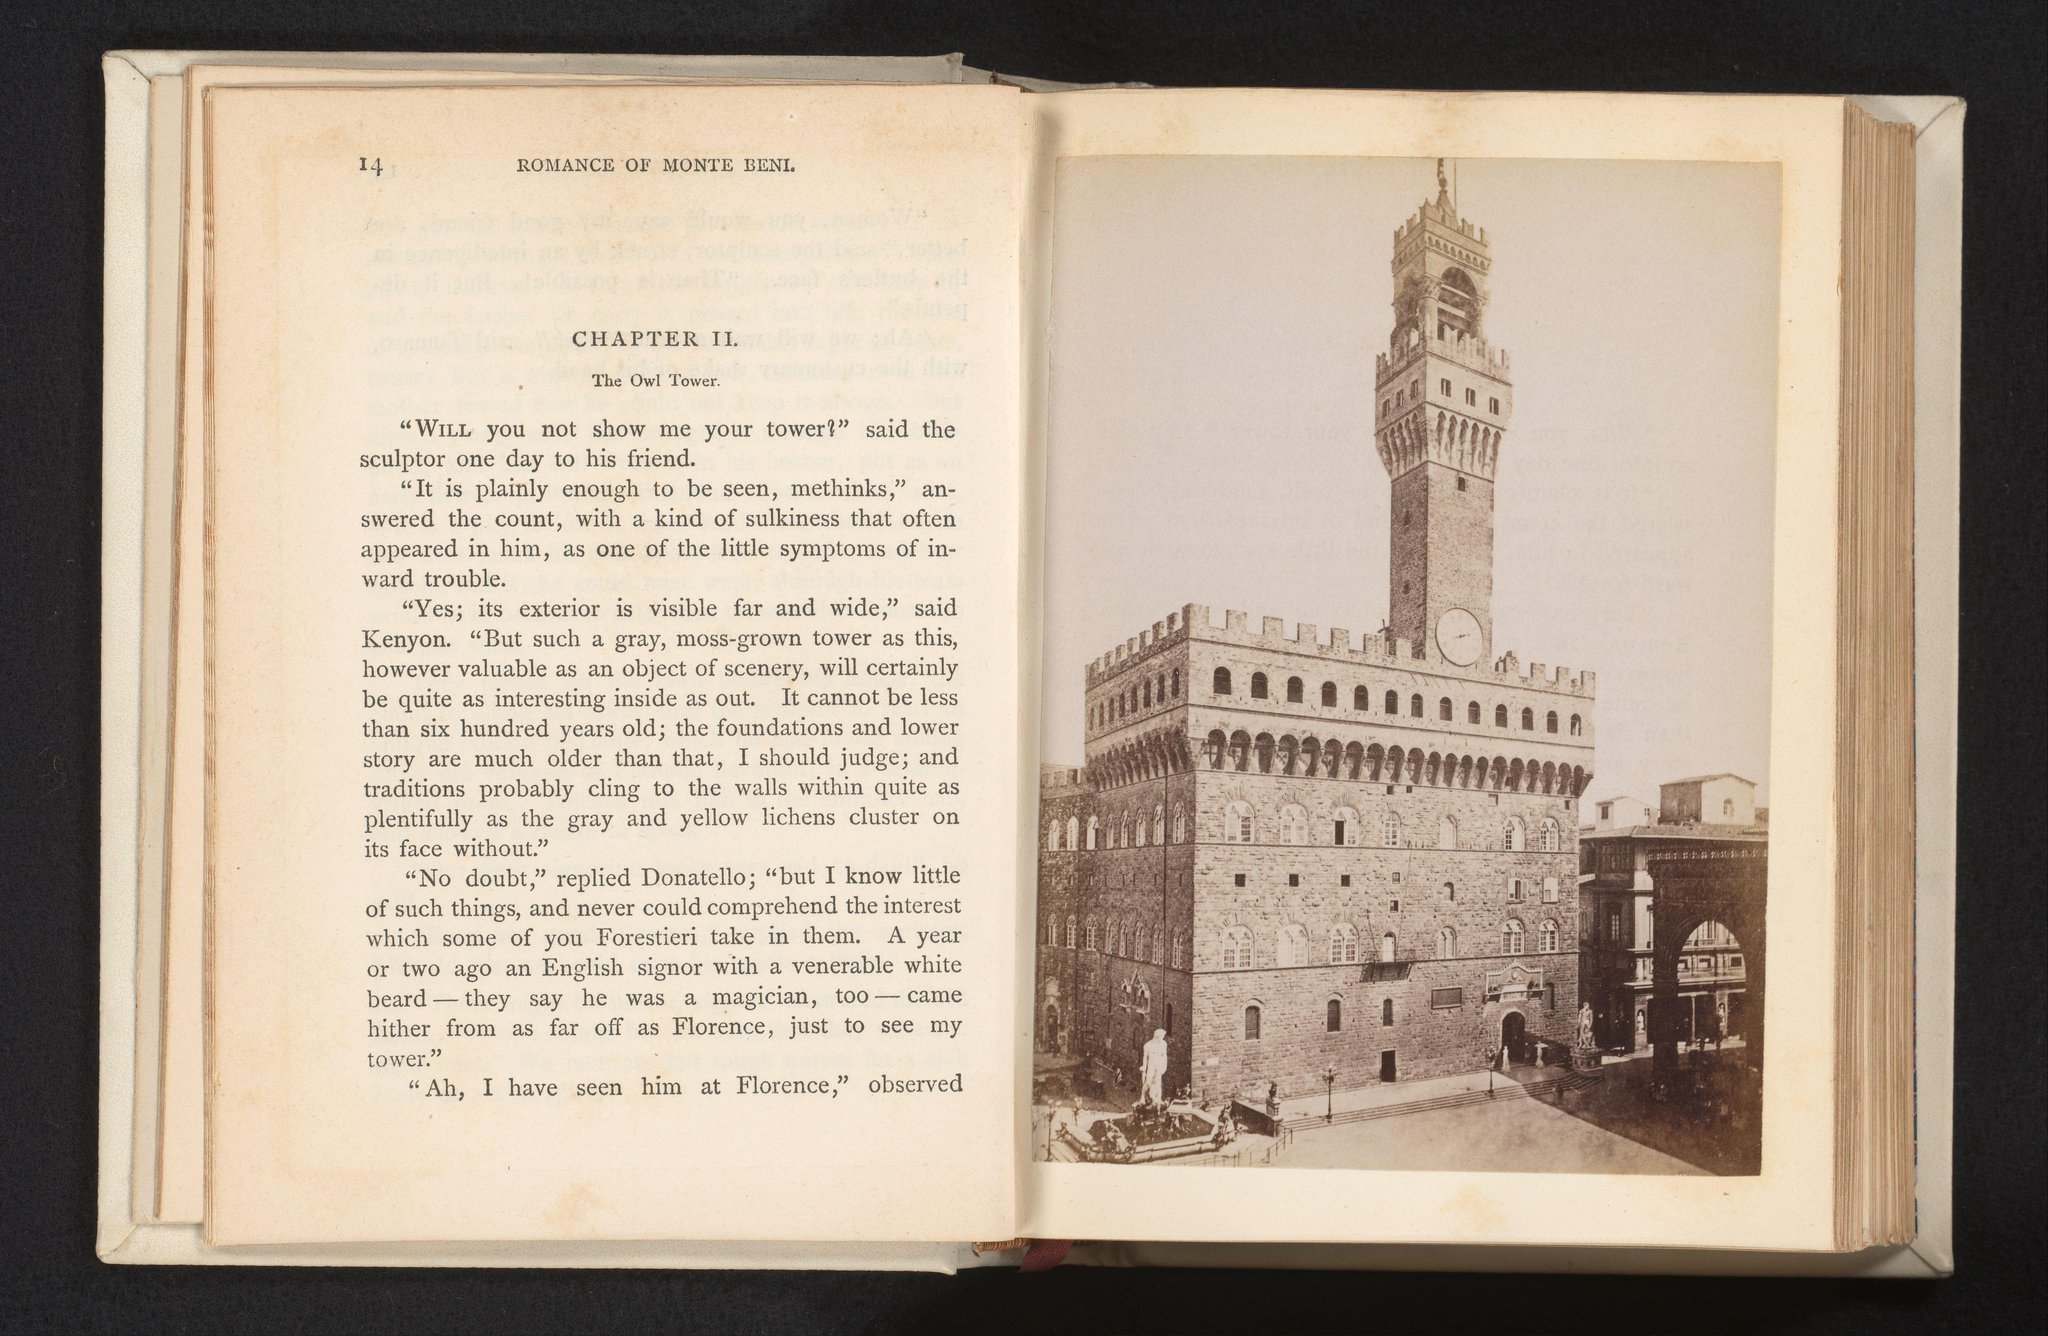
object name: photograph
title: Gezicht op Palazzo Vecchio in Florence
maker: Anonymous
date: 1850-1860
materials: photographic support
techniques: albumen print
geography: florence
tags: tower, clock tower ~ monumental adornment, palace